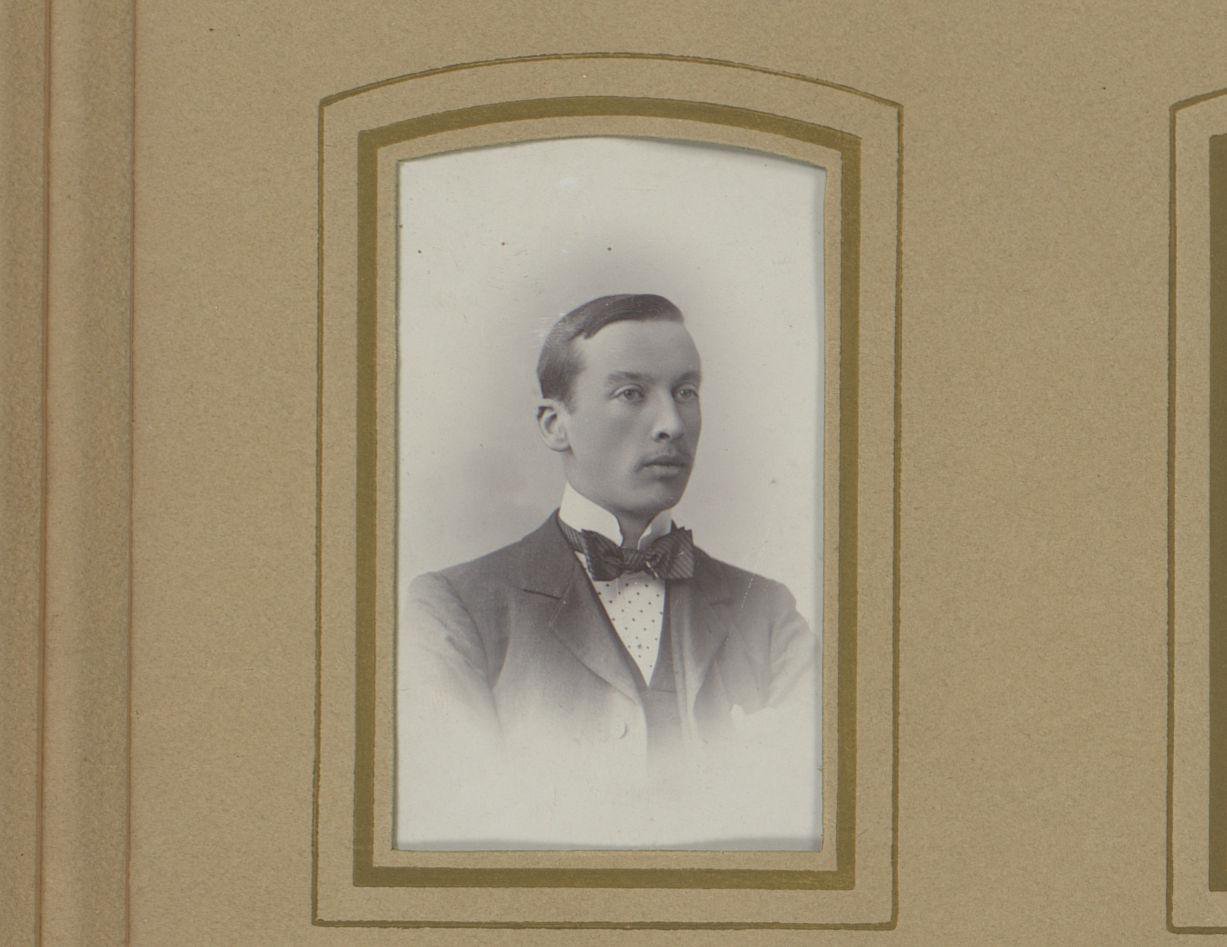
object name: album leaf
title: Portret van een man met vlinderstrik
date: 1894-1907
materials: cardboard, photographic support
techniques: matte daylight collodion silver print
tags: historical persons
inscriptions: inscription: ‘[Koene & Büttinghausen]/ Amsterdam/ Heerengracht [150.]/ Batavia.’